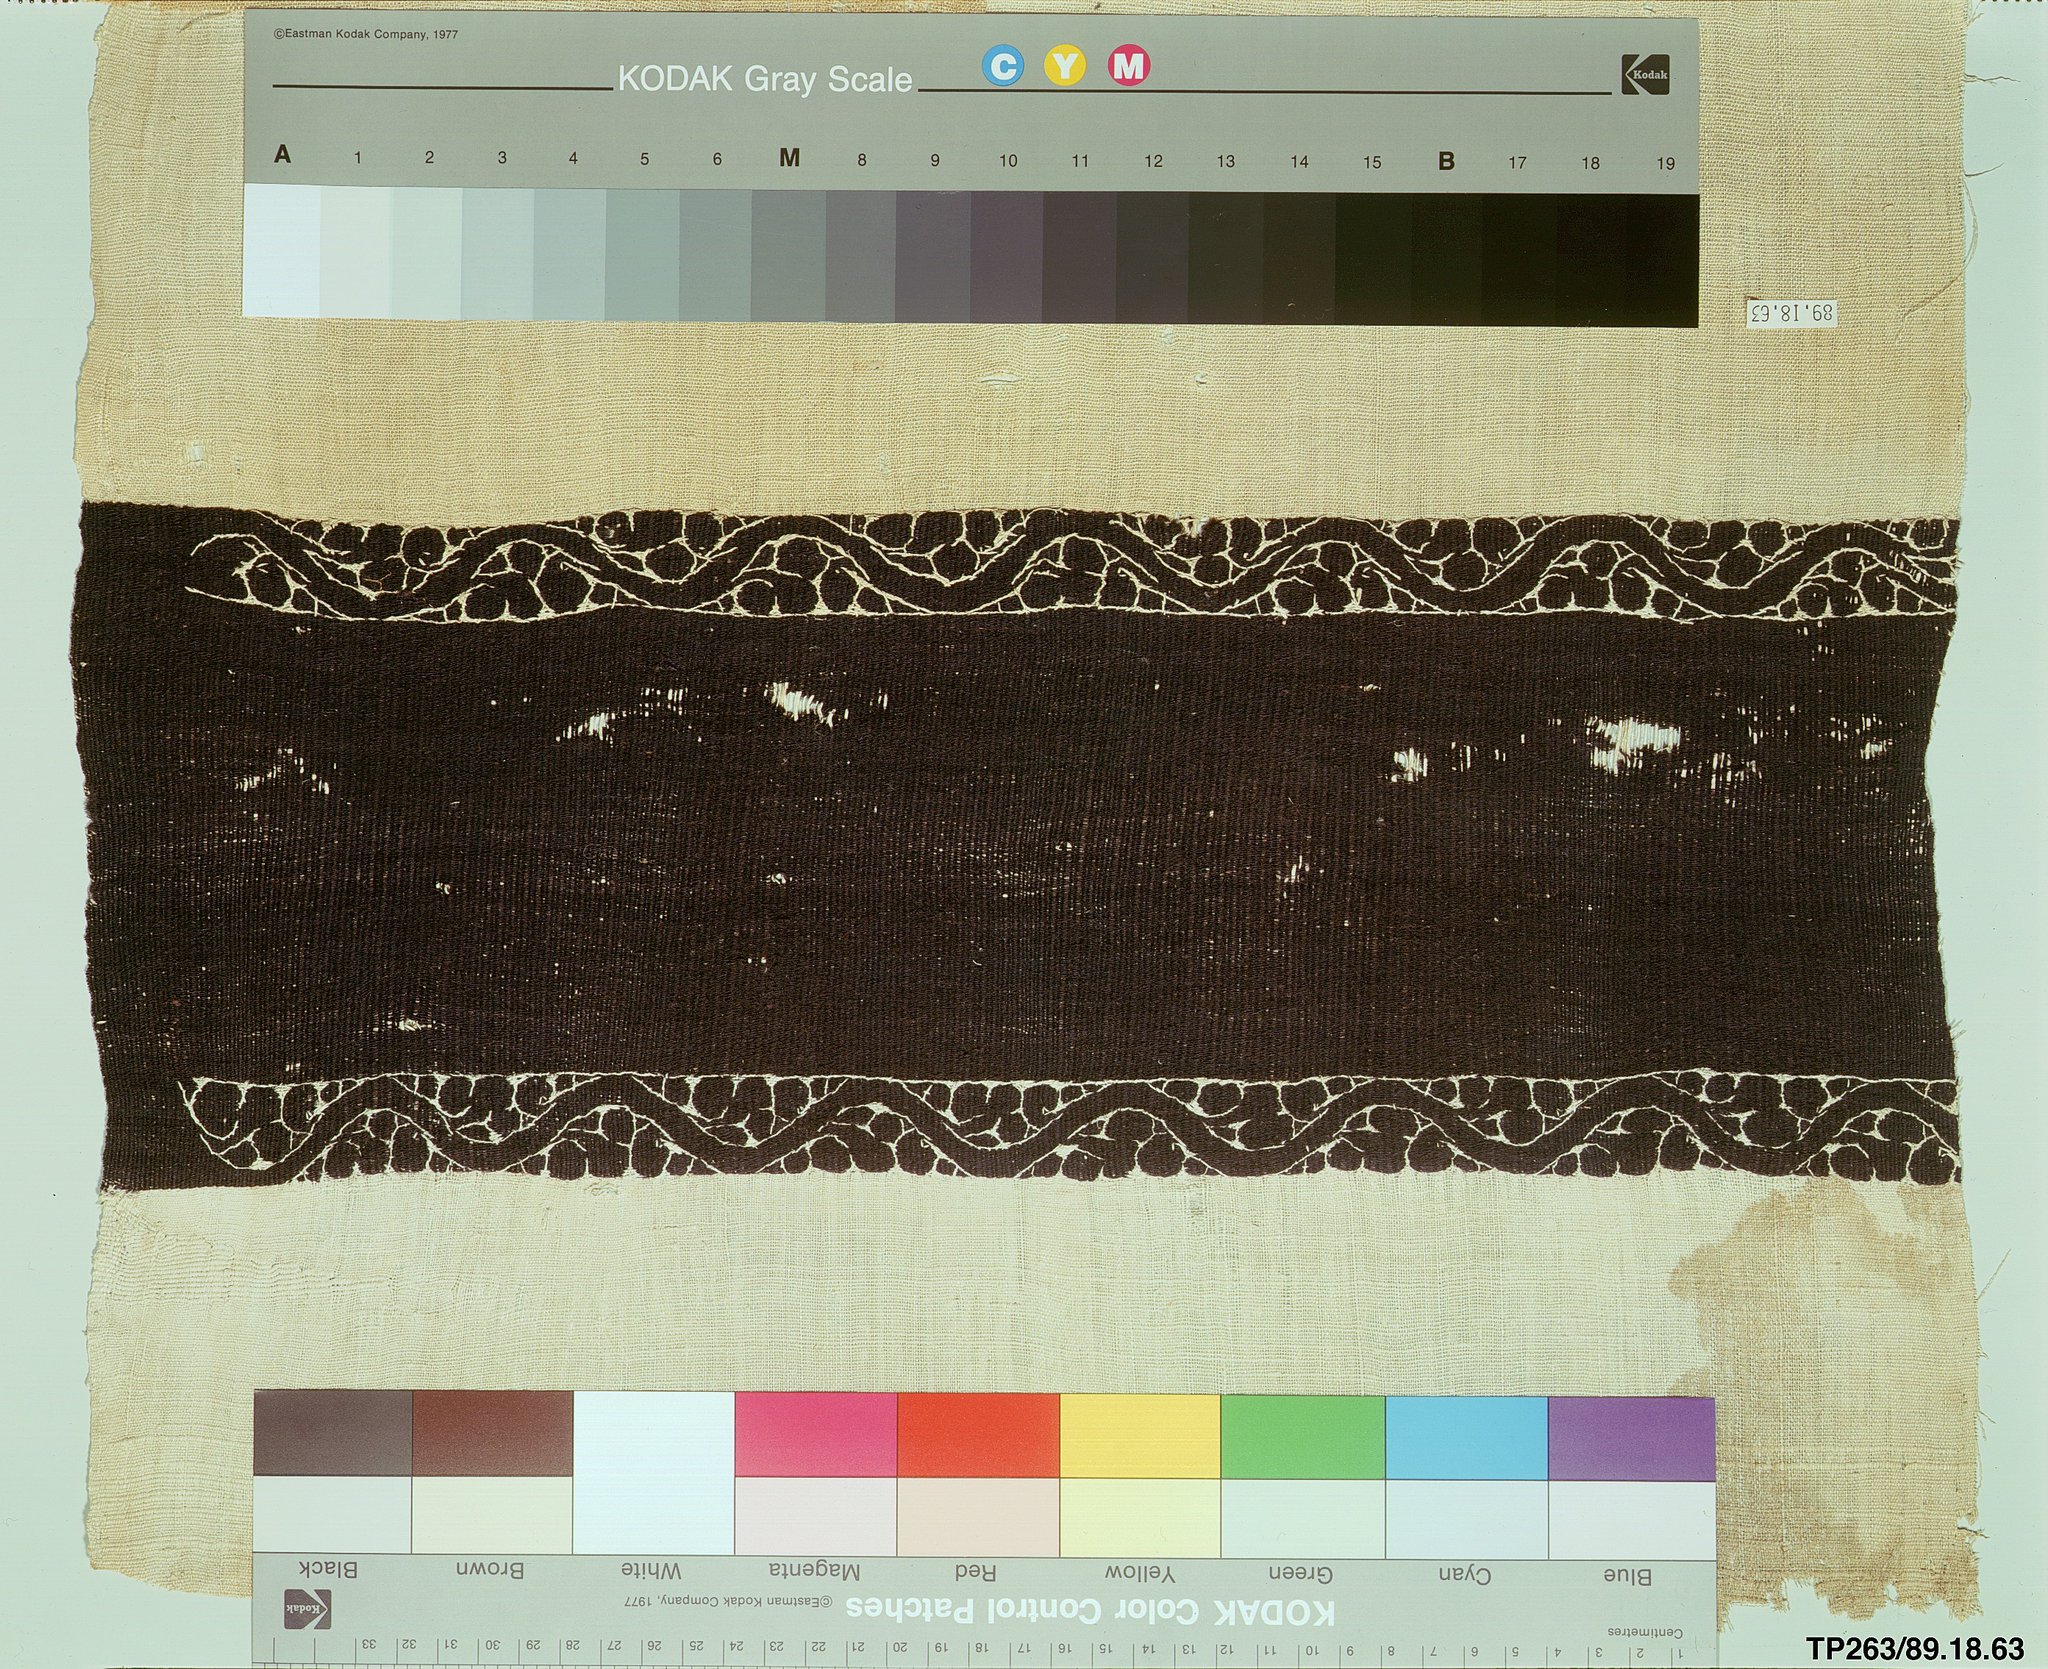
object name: textile fragment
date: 201-400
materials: linen, wool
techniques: weave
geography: egypt